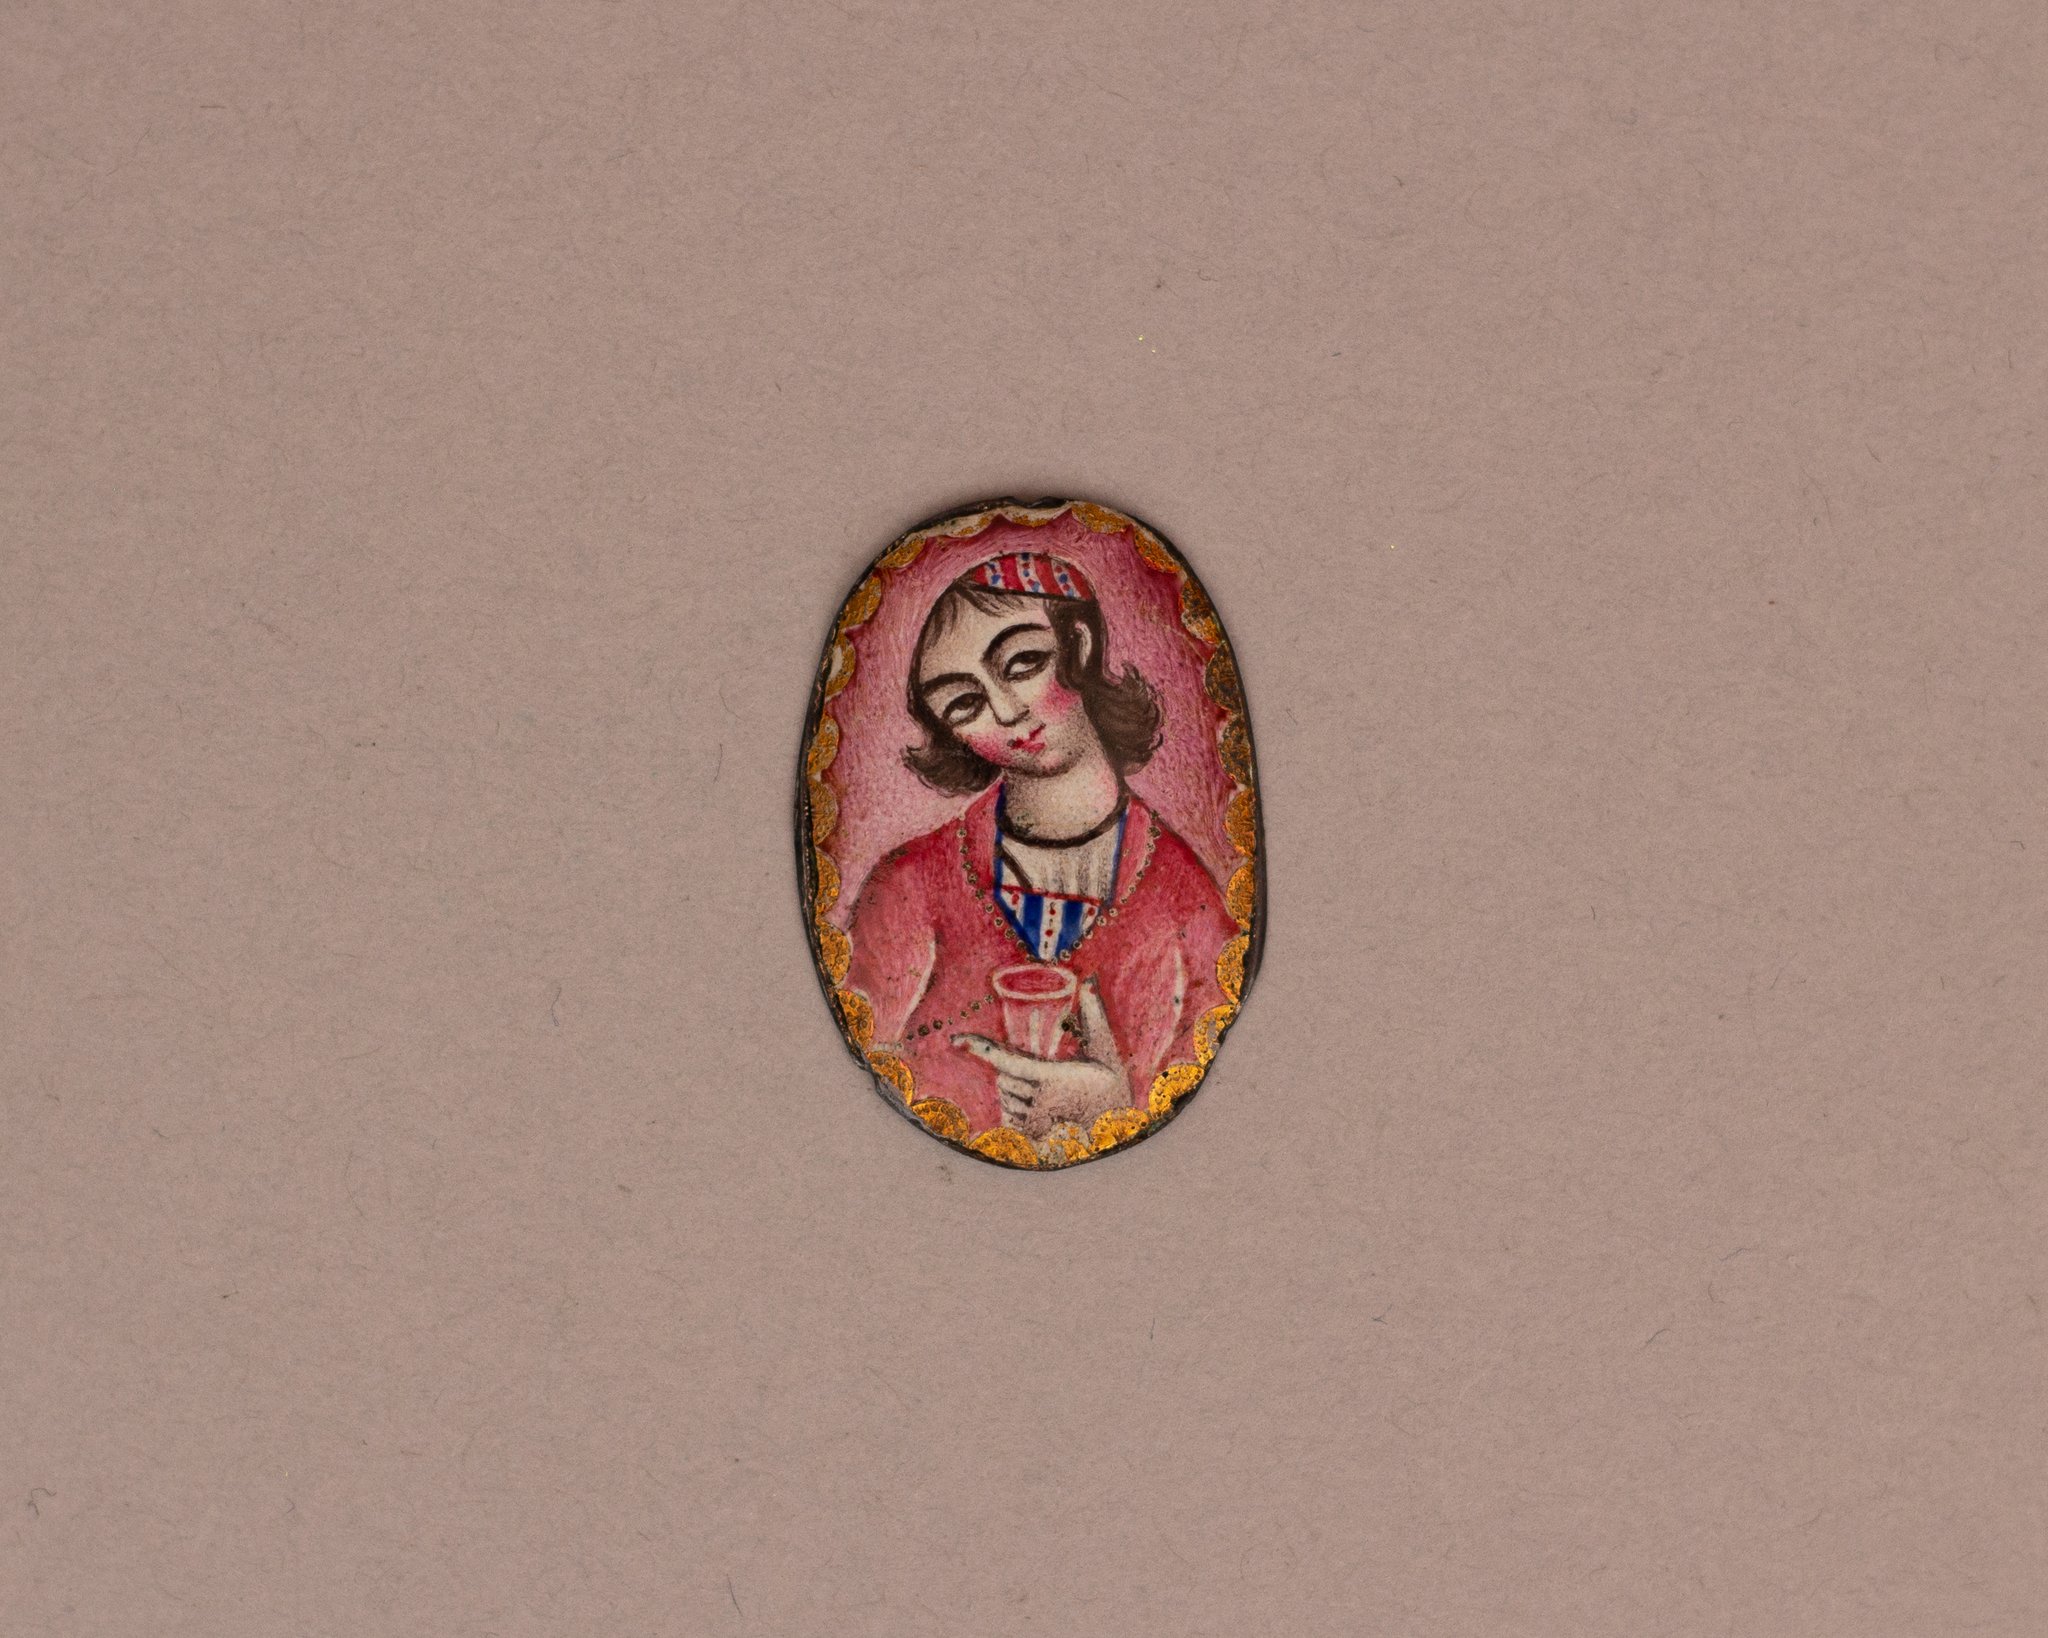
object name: disk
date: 1767-1800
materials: enamel, gold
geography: iran